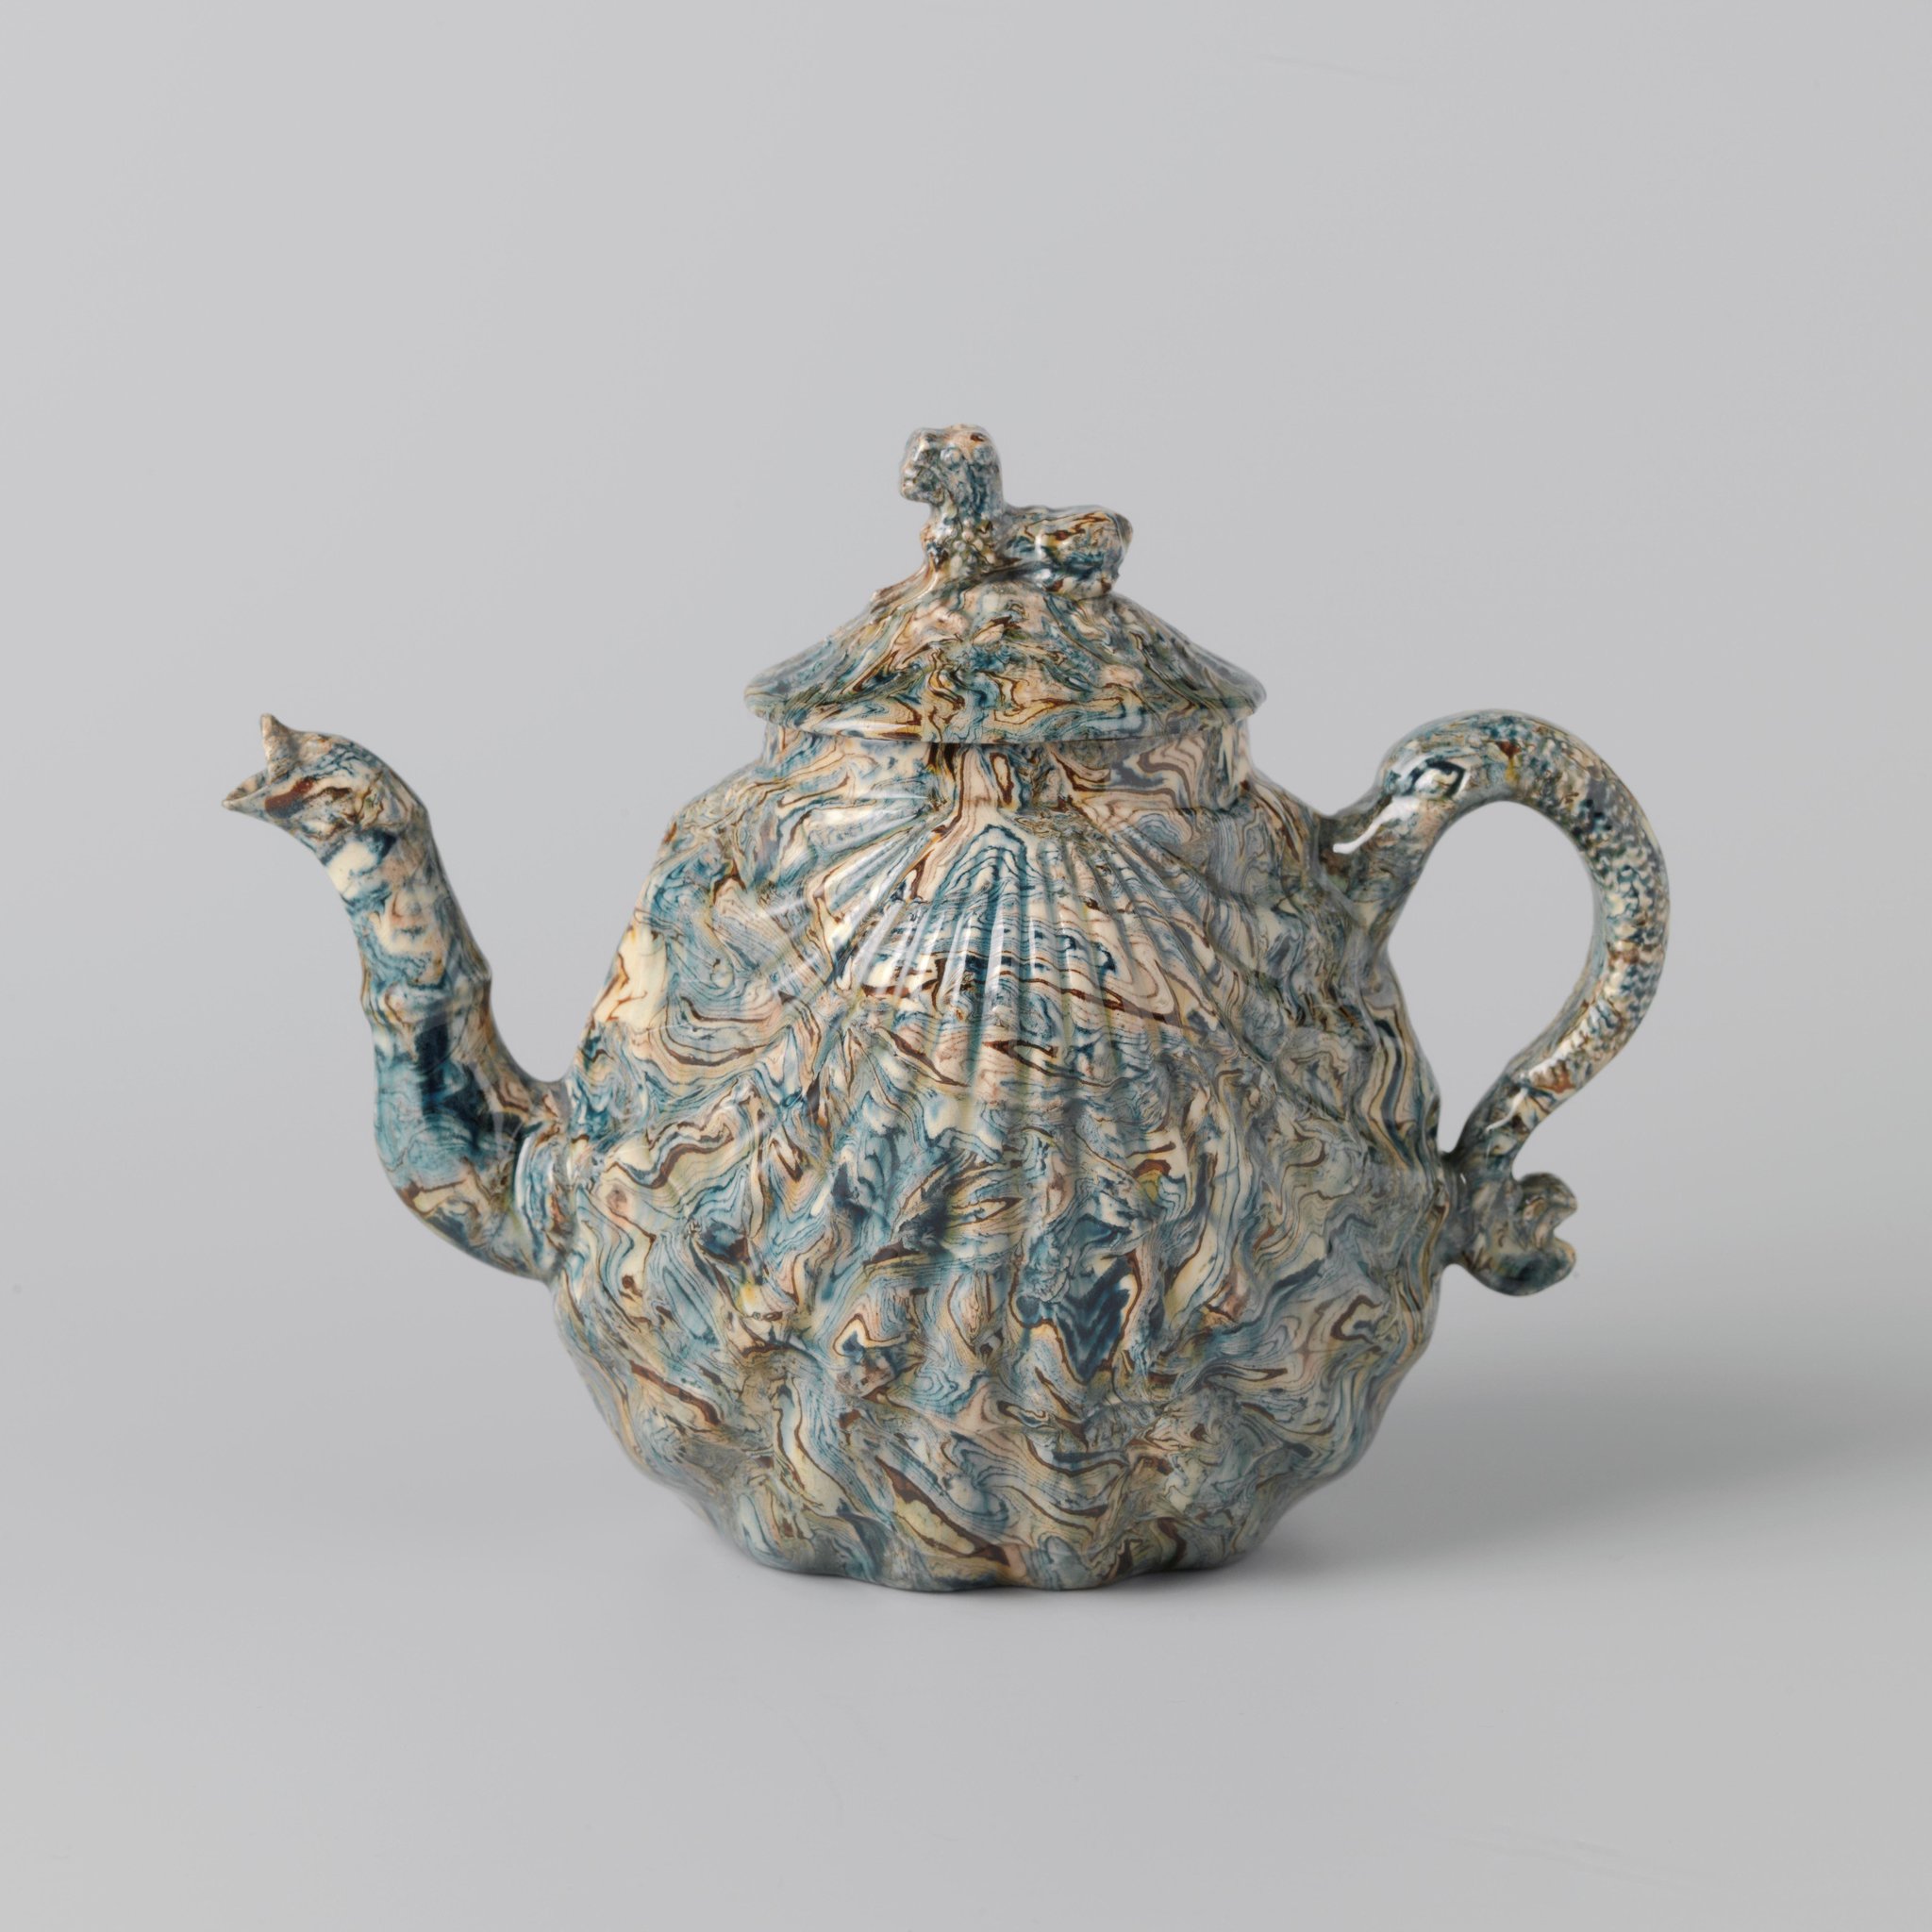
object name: teapot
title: Deksel van hardgebakken aardewerk; Staffordshire (zgn. Whieldon, agate ware).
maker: Anonymous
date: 1750-1760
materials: earthenware, glaze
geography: england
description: Het gewelfde deksel heeft een liggende leeuw als knop en het oor heeft het uiterlijk van een slang. Het glazuur is gemarmerd in de kleuren blauw, groen, geel en bruin.